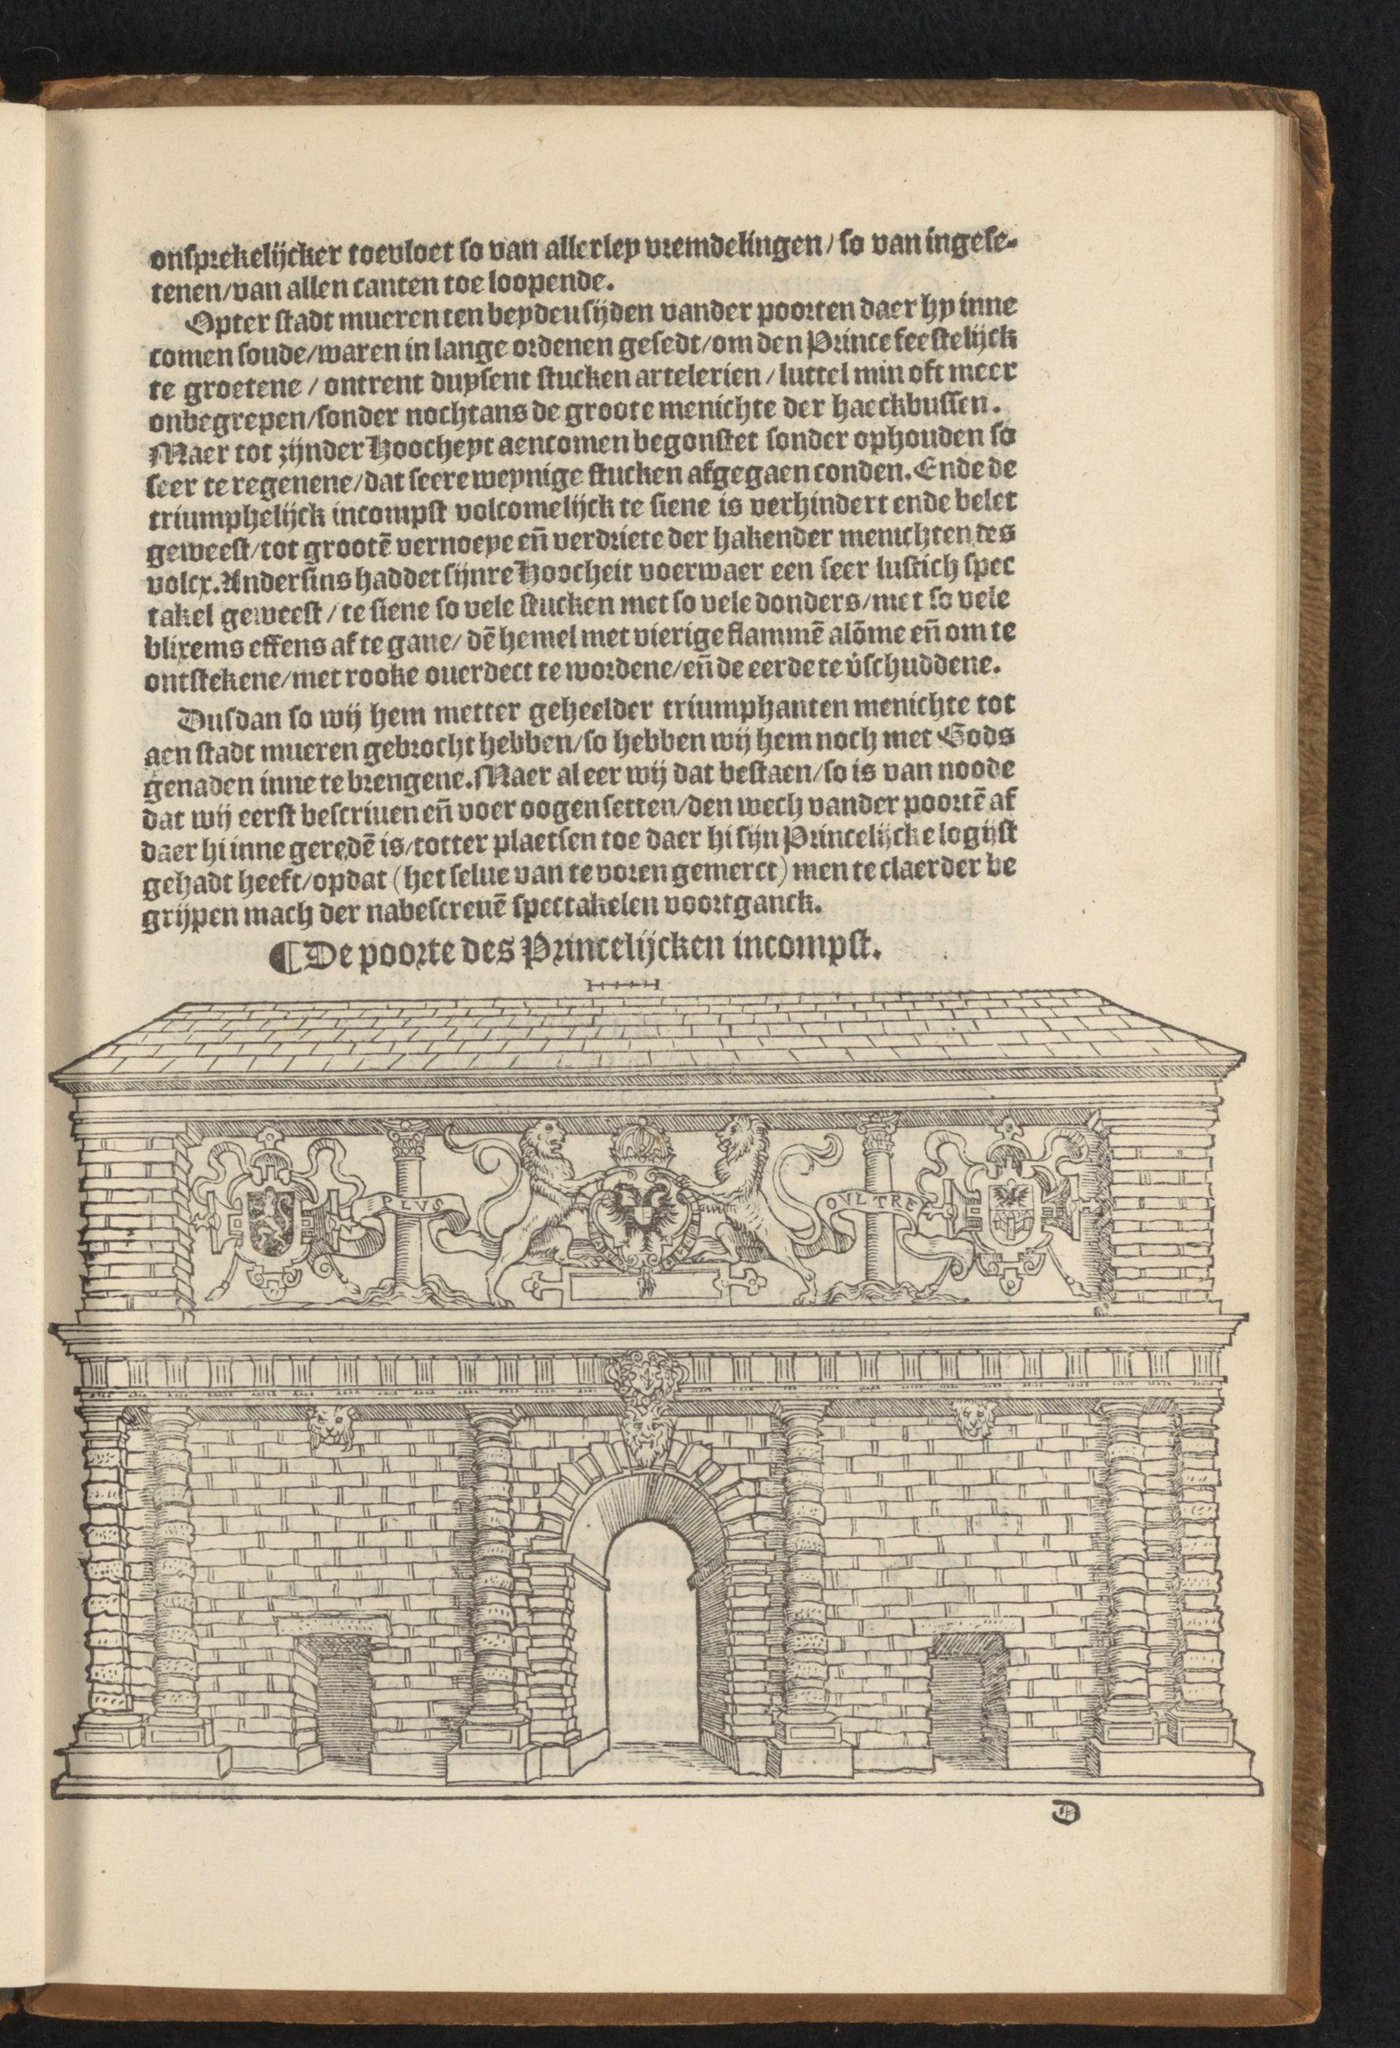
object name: print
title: De Keizerspoort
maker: pieter coecke van aelst (i)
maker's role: draughtsman, print maker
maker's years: 1502-1550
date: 1549-1550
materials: paper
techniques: woodcut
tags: philip ii of spain, triumphal arch, antwerp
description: Illustratie in de Nederlandse vertaling van de beschrijving van de intocht van Filips II in Antwerpen in 1549: De seer wonderlijcke schoone triumphelijcke incompst, van den hooghmogenden Prince Philips, Prince van Spaignen, Caroli des vijfden, Keysers sone : inde stadt van Antwerpen, Anno 1549. Tekst van Cornelius Grapheus, waarschijnlijk vertaald uit het Latijn door Gillis van Diest, opgedragen aan Filips II, uitgegeven met keizerlijke privilege door Pieter Coecke van Aelst, gedrukt door Gillis van Diest. Boek in de bibliotheek met signatuur: 325 B 12.